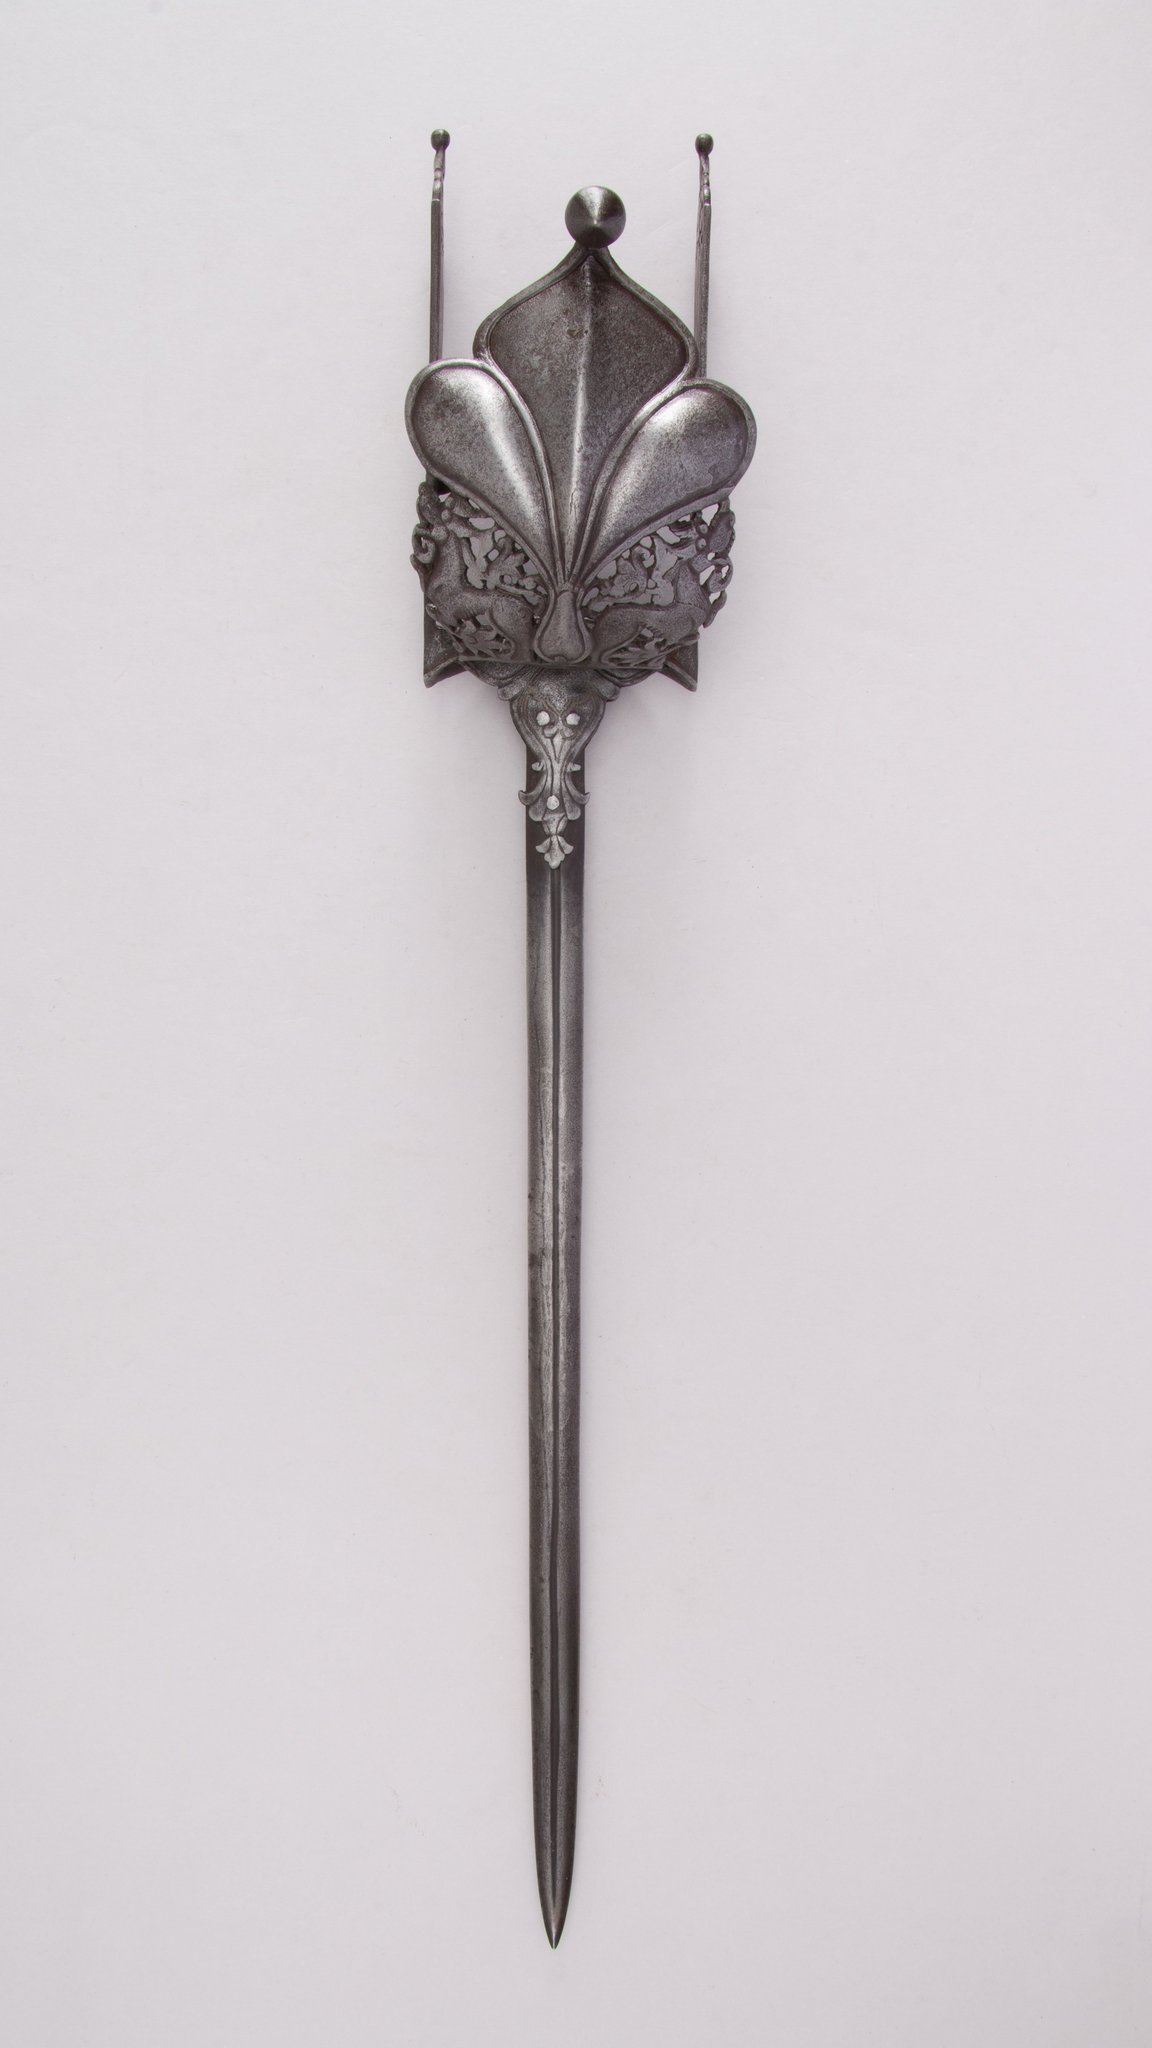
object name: dagger katar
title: Dagger (Katar)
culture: indian or european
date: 1501-1600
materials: steel